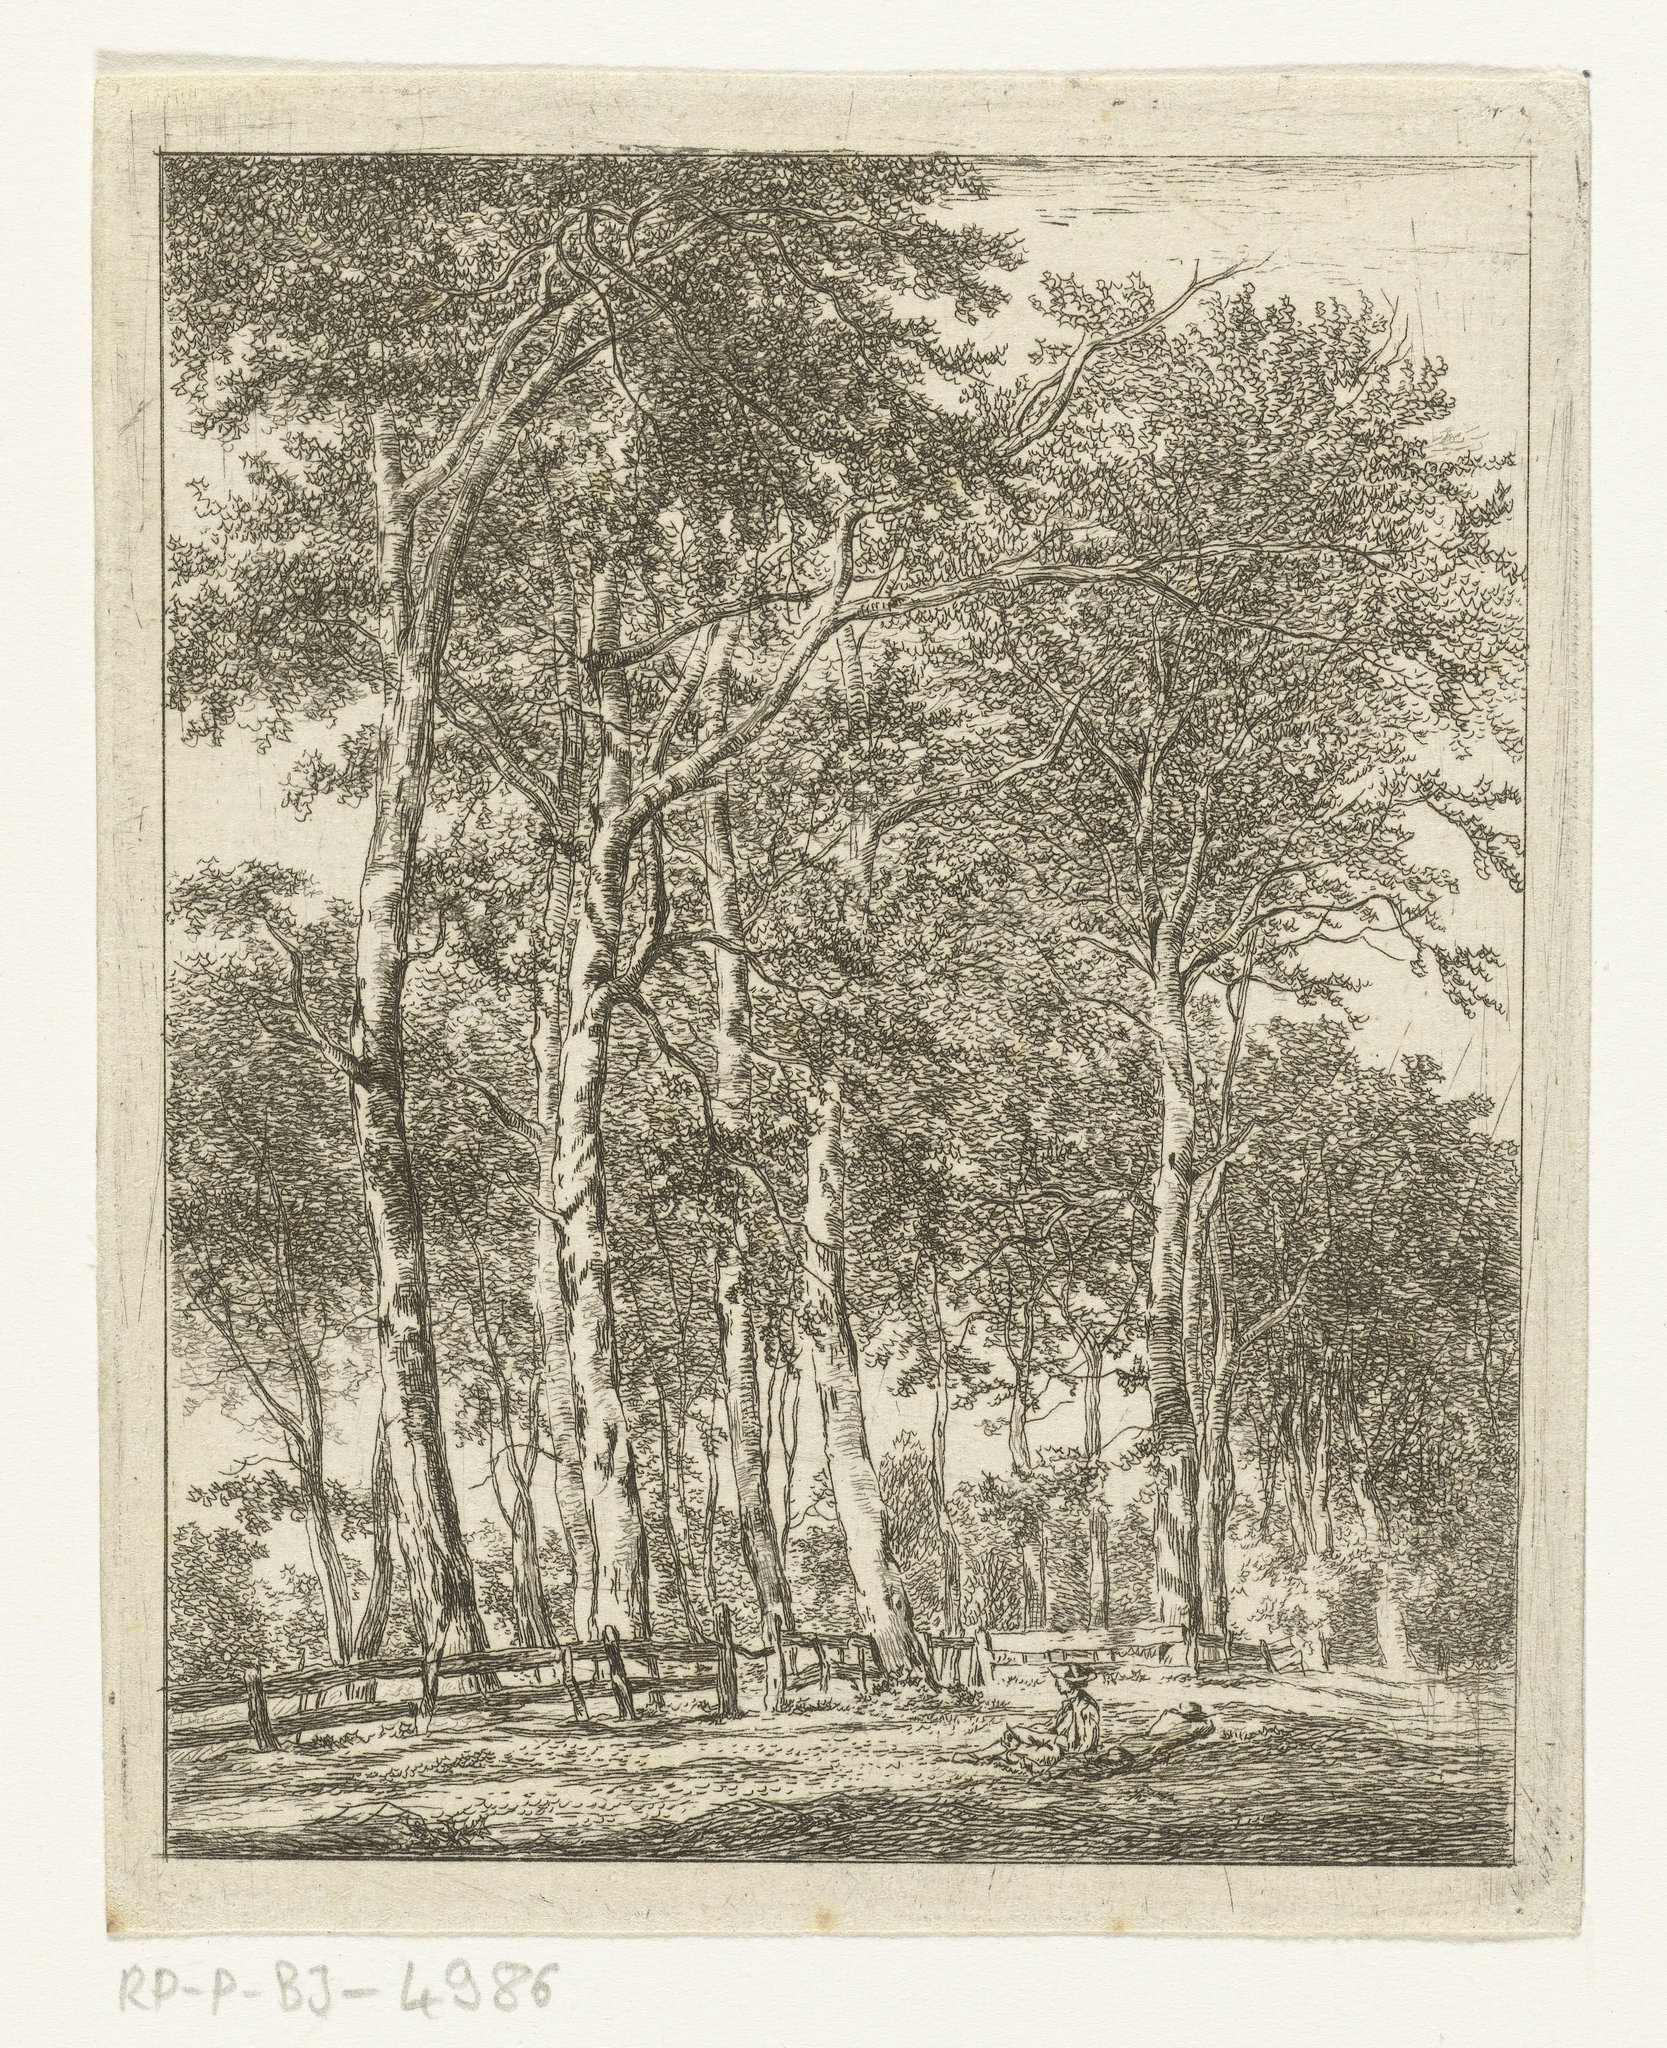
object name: print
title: Rustende figuren bij hoge bomen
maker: hermanus van brussel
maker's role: draughtsman, print maker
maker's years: 1763-1815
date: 1800-1815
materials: paper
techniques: etching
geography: netherlands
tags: landscapes in the temperate zone, forest, wood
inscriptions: collector's mark: Lugt 2228